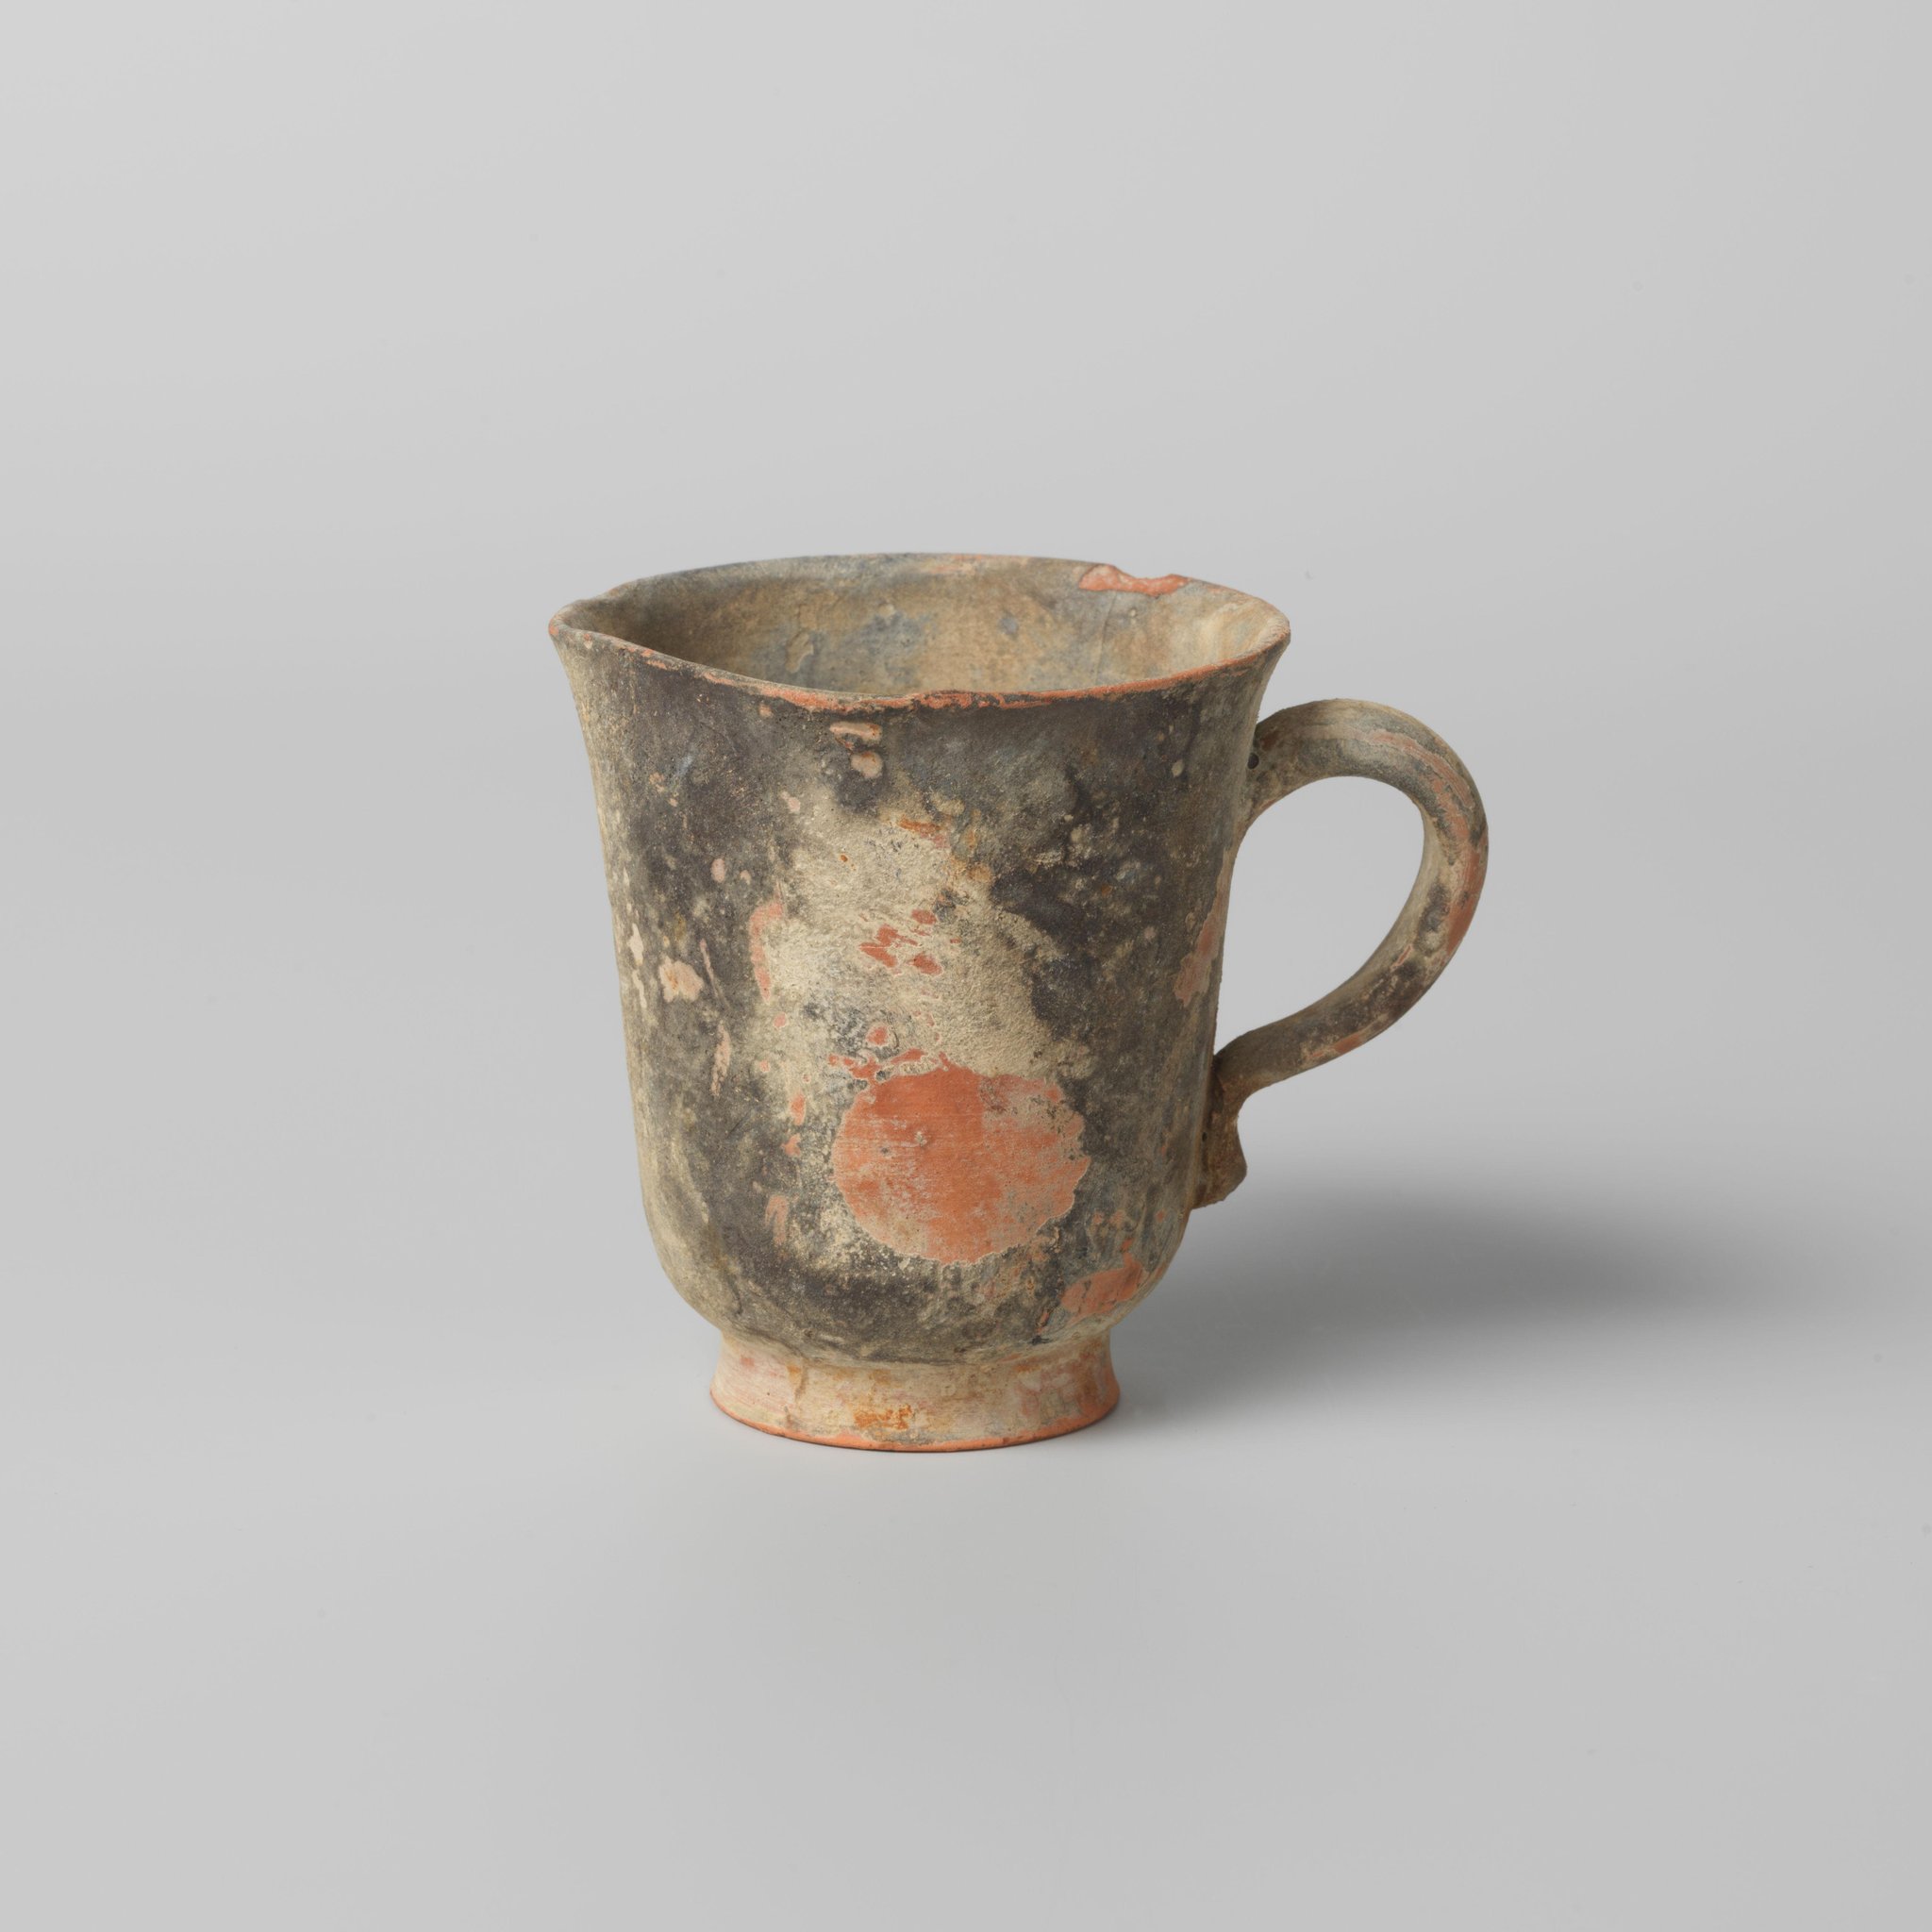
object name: bakafval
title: Hoge klokvormige oorkop (De Caluwe bakafval)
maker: jacobus de caluwe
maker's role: plateelbakkerij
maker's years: -1730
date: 1700-1725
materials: earthenware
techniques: firing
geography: delft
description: Toegeschreven aan Jacobus de Caluwe, omdat dit voorwerp samen met gemerkte stukken (‘Jacobus De Caluwe’ en rennend hert) gevonden is op de plaats waar zich De Caluwes tweede werkplaats bevond. Er is een duidelijke stilistische overeenkomst tussen de gemerkte en niet gemerkte voorwerpen uit deze archeologische vondst.